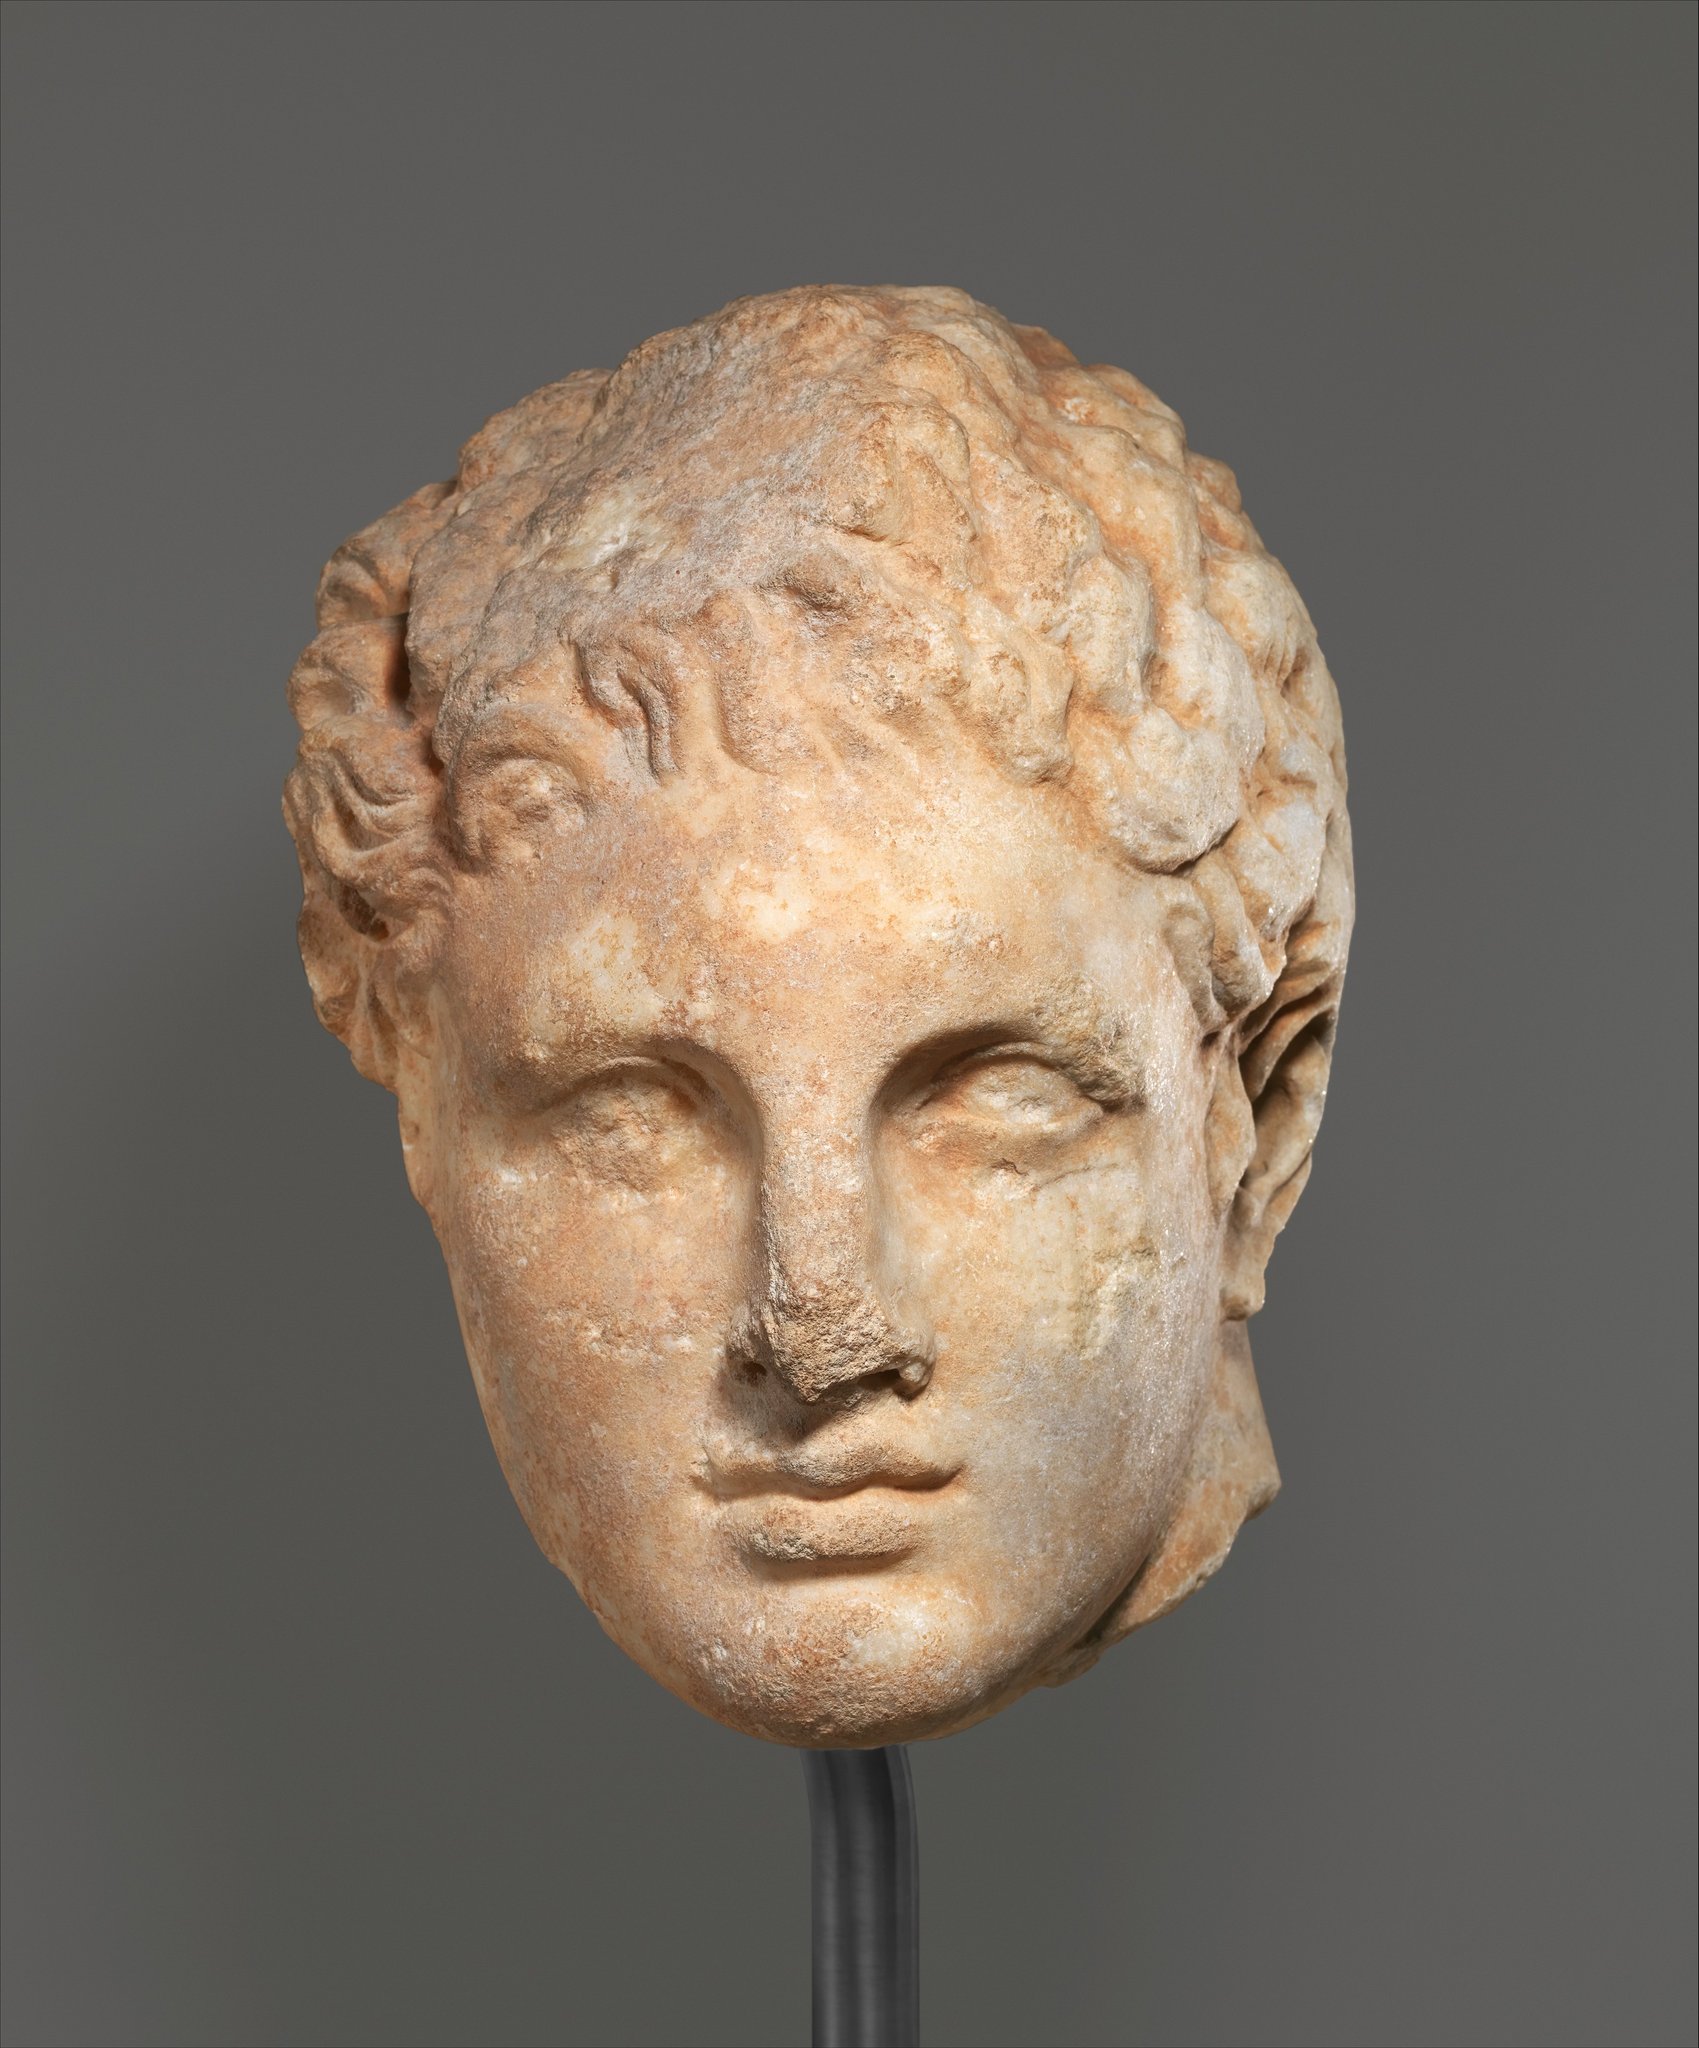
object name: relief fragment, head of a youth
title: Marble head of a youth from a relief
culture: greek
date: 334-301 BCE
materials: marble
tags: heads,men